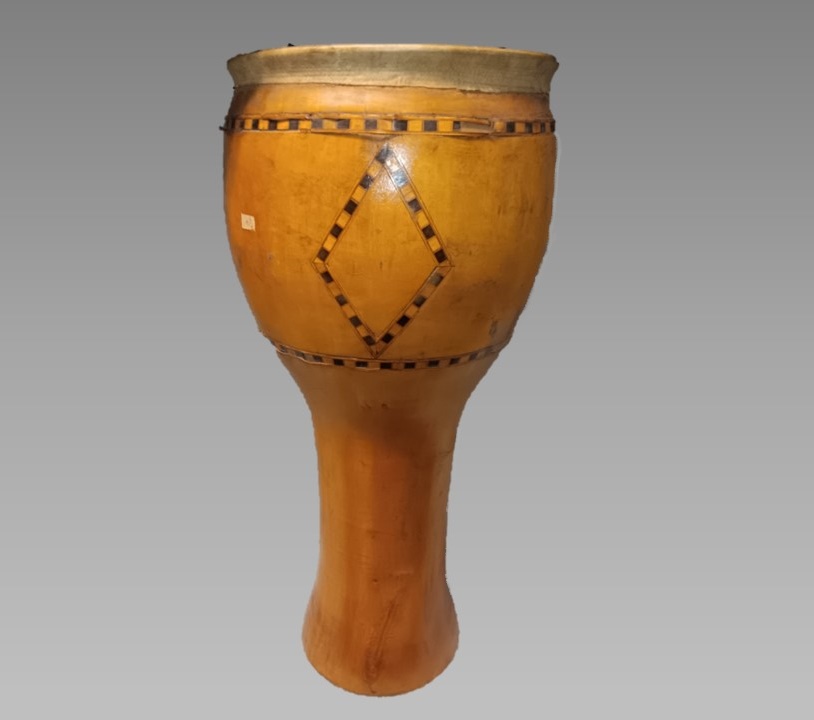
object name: darabukka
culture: syrian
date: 1867-1900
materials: parchment, skin, wood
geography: syria